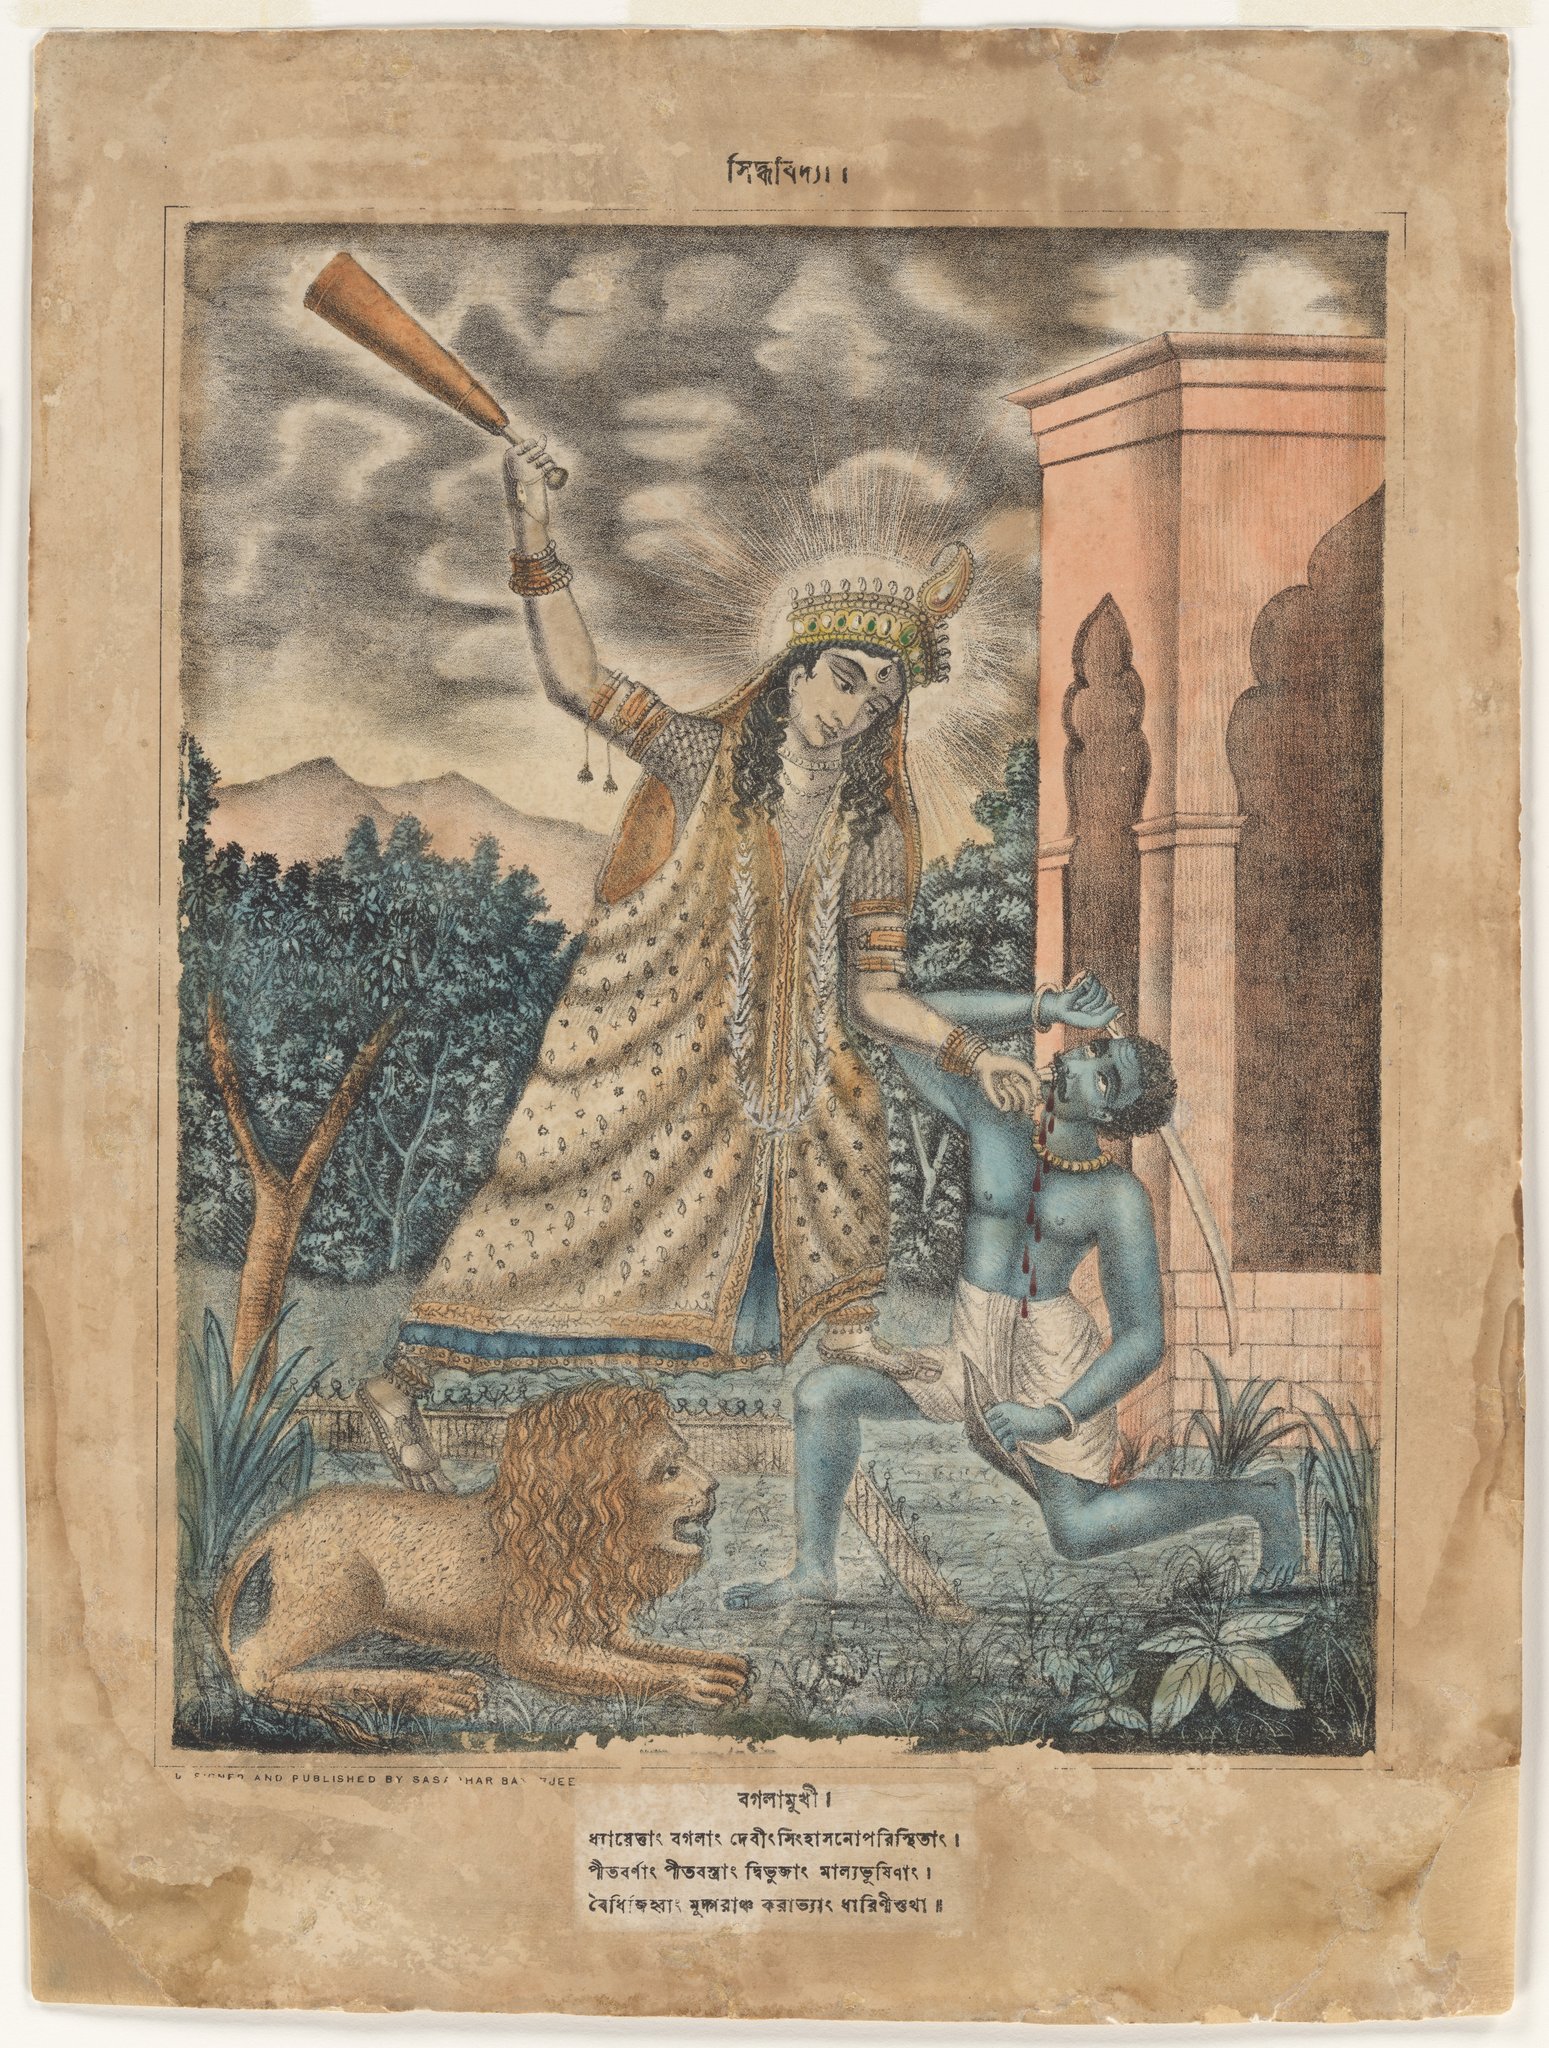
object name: print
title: Goddess Bagala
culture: west bengali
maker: sasadhar banarjee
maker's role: artist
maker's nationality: indian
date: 1875-1885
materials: glaze, watercolor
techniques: hand coloring, lithograph, printing